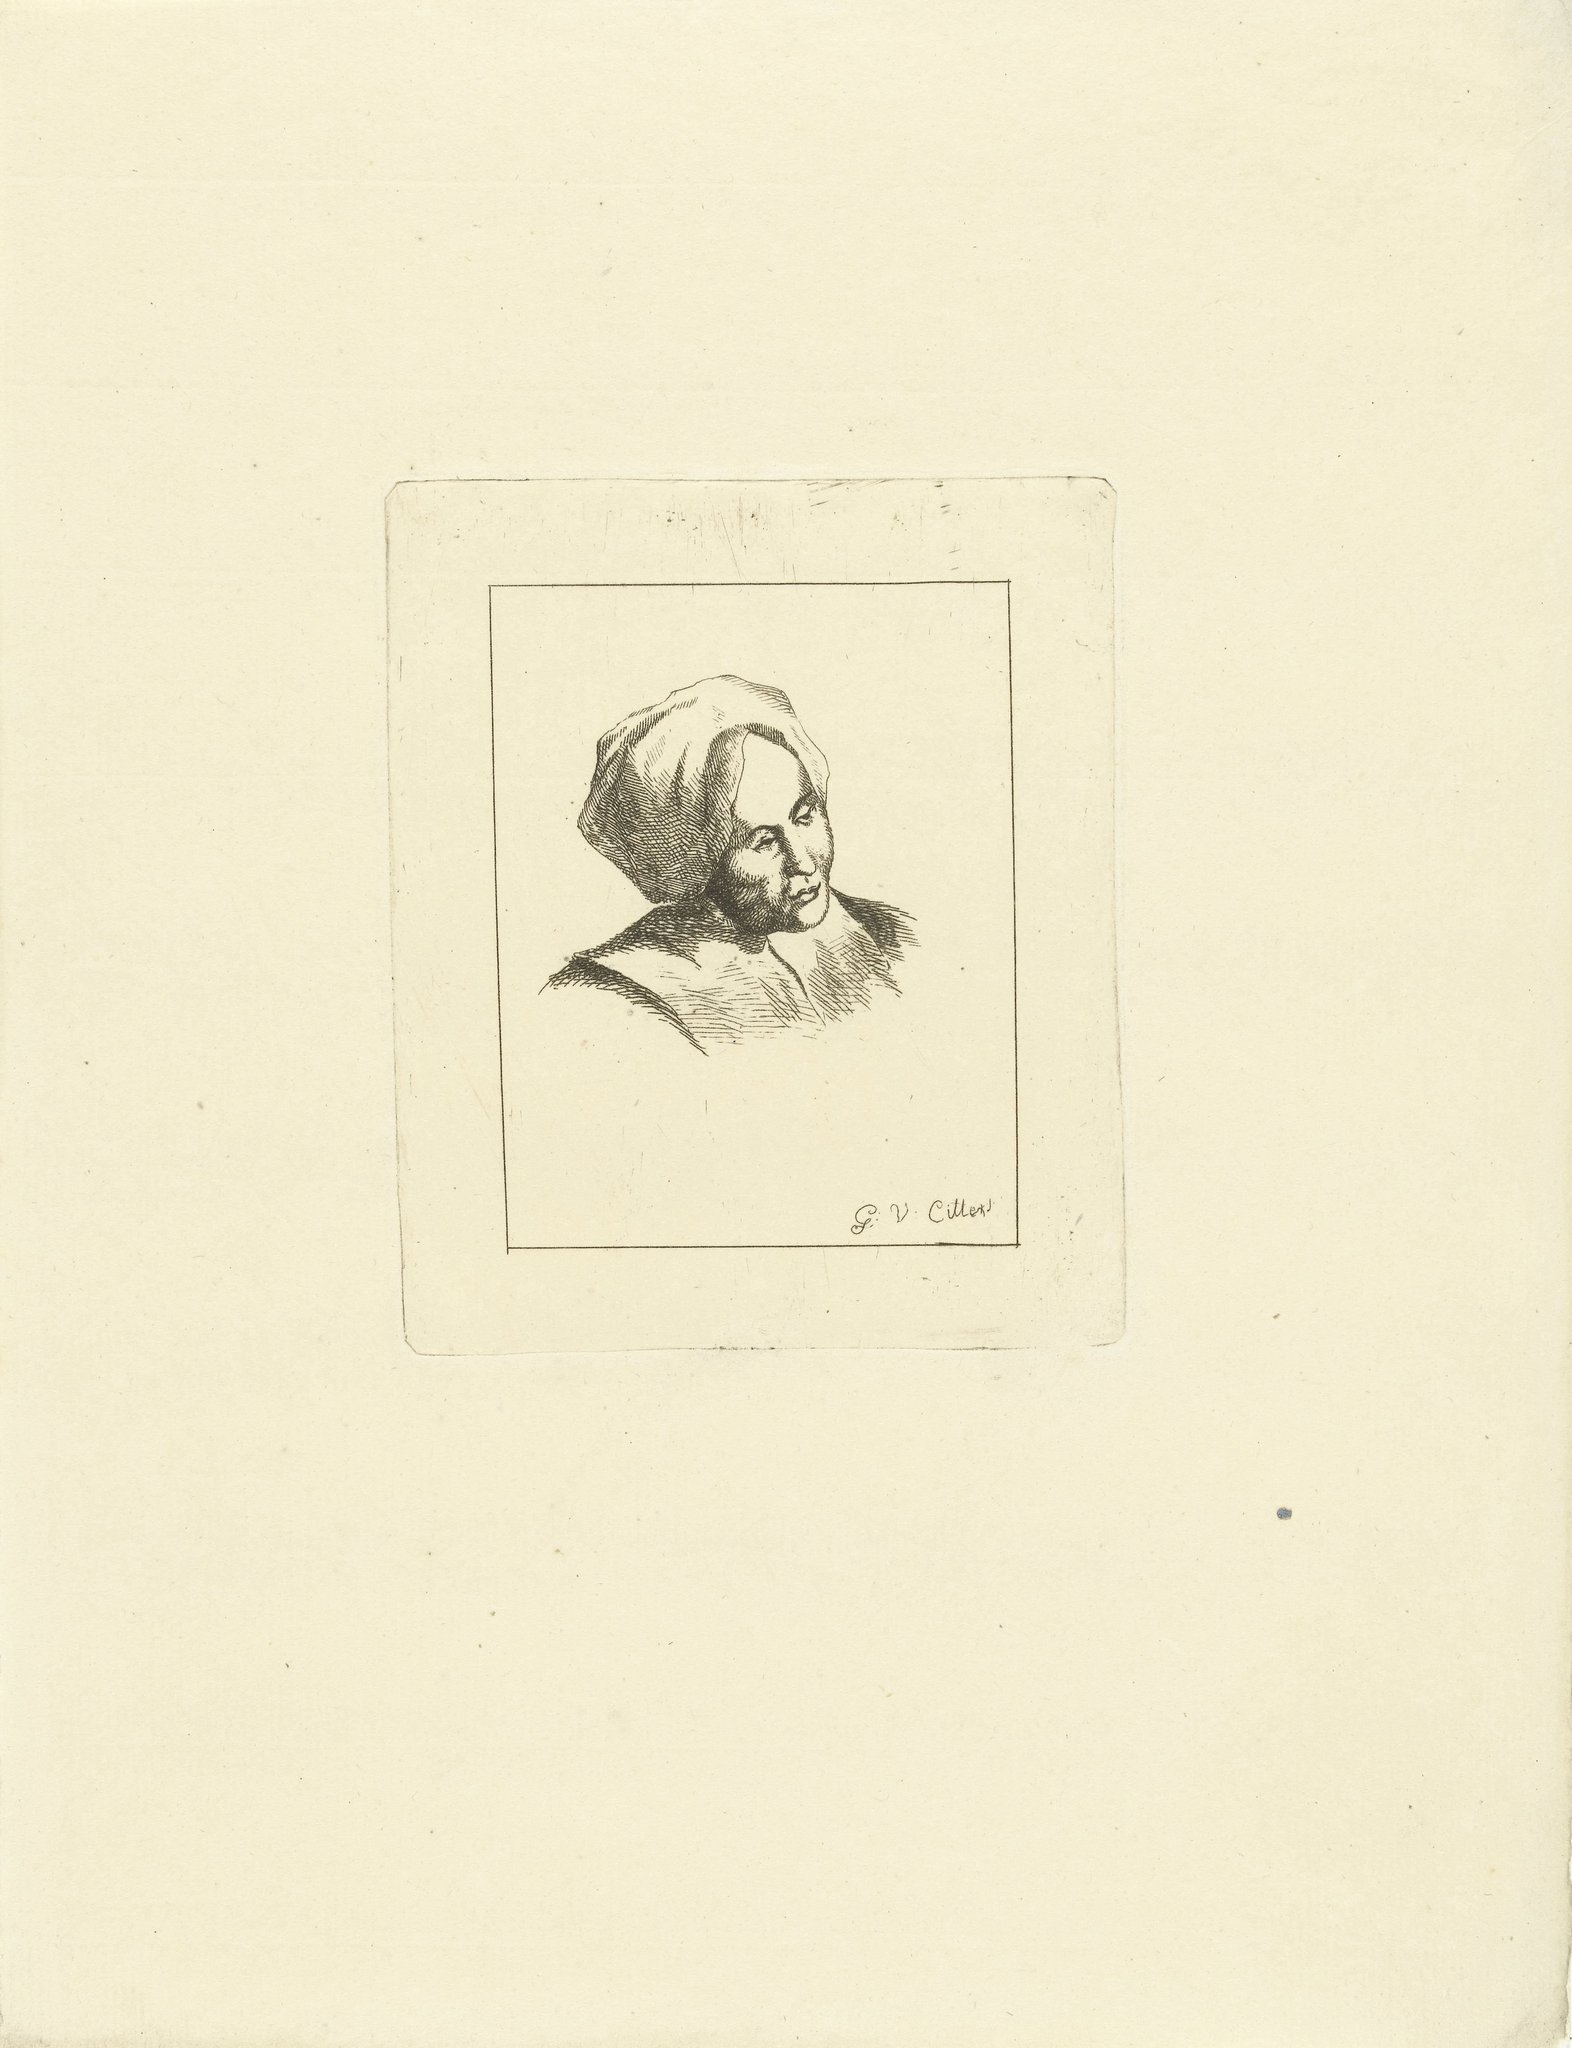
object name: print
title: Hoofdstudie van een vrouw met hoofddoek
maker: g. van citters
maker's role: print maker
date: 1750-1800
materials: paper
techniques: etching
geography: netherlands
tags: head-gear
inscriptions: collector's mark: Lugt 2233